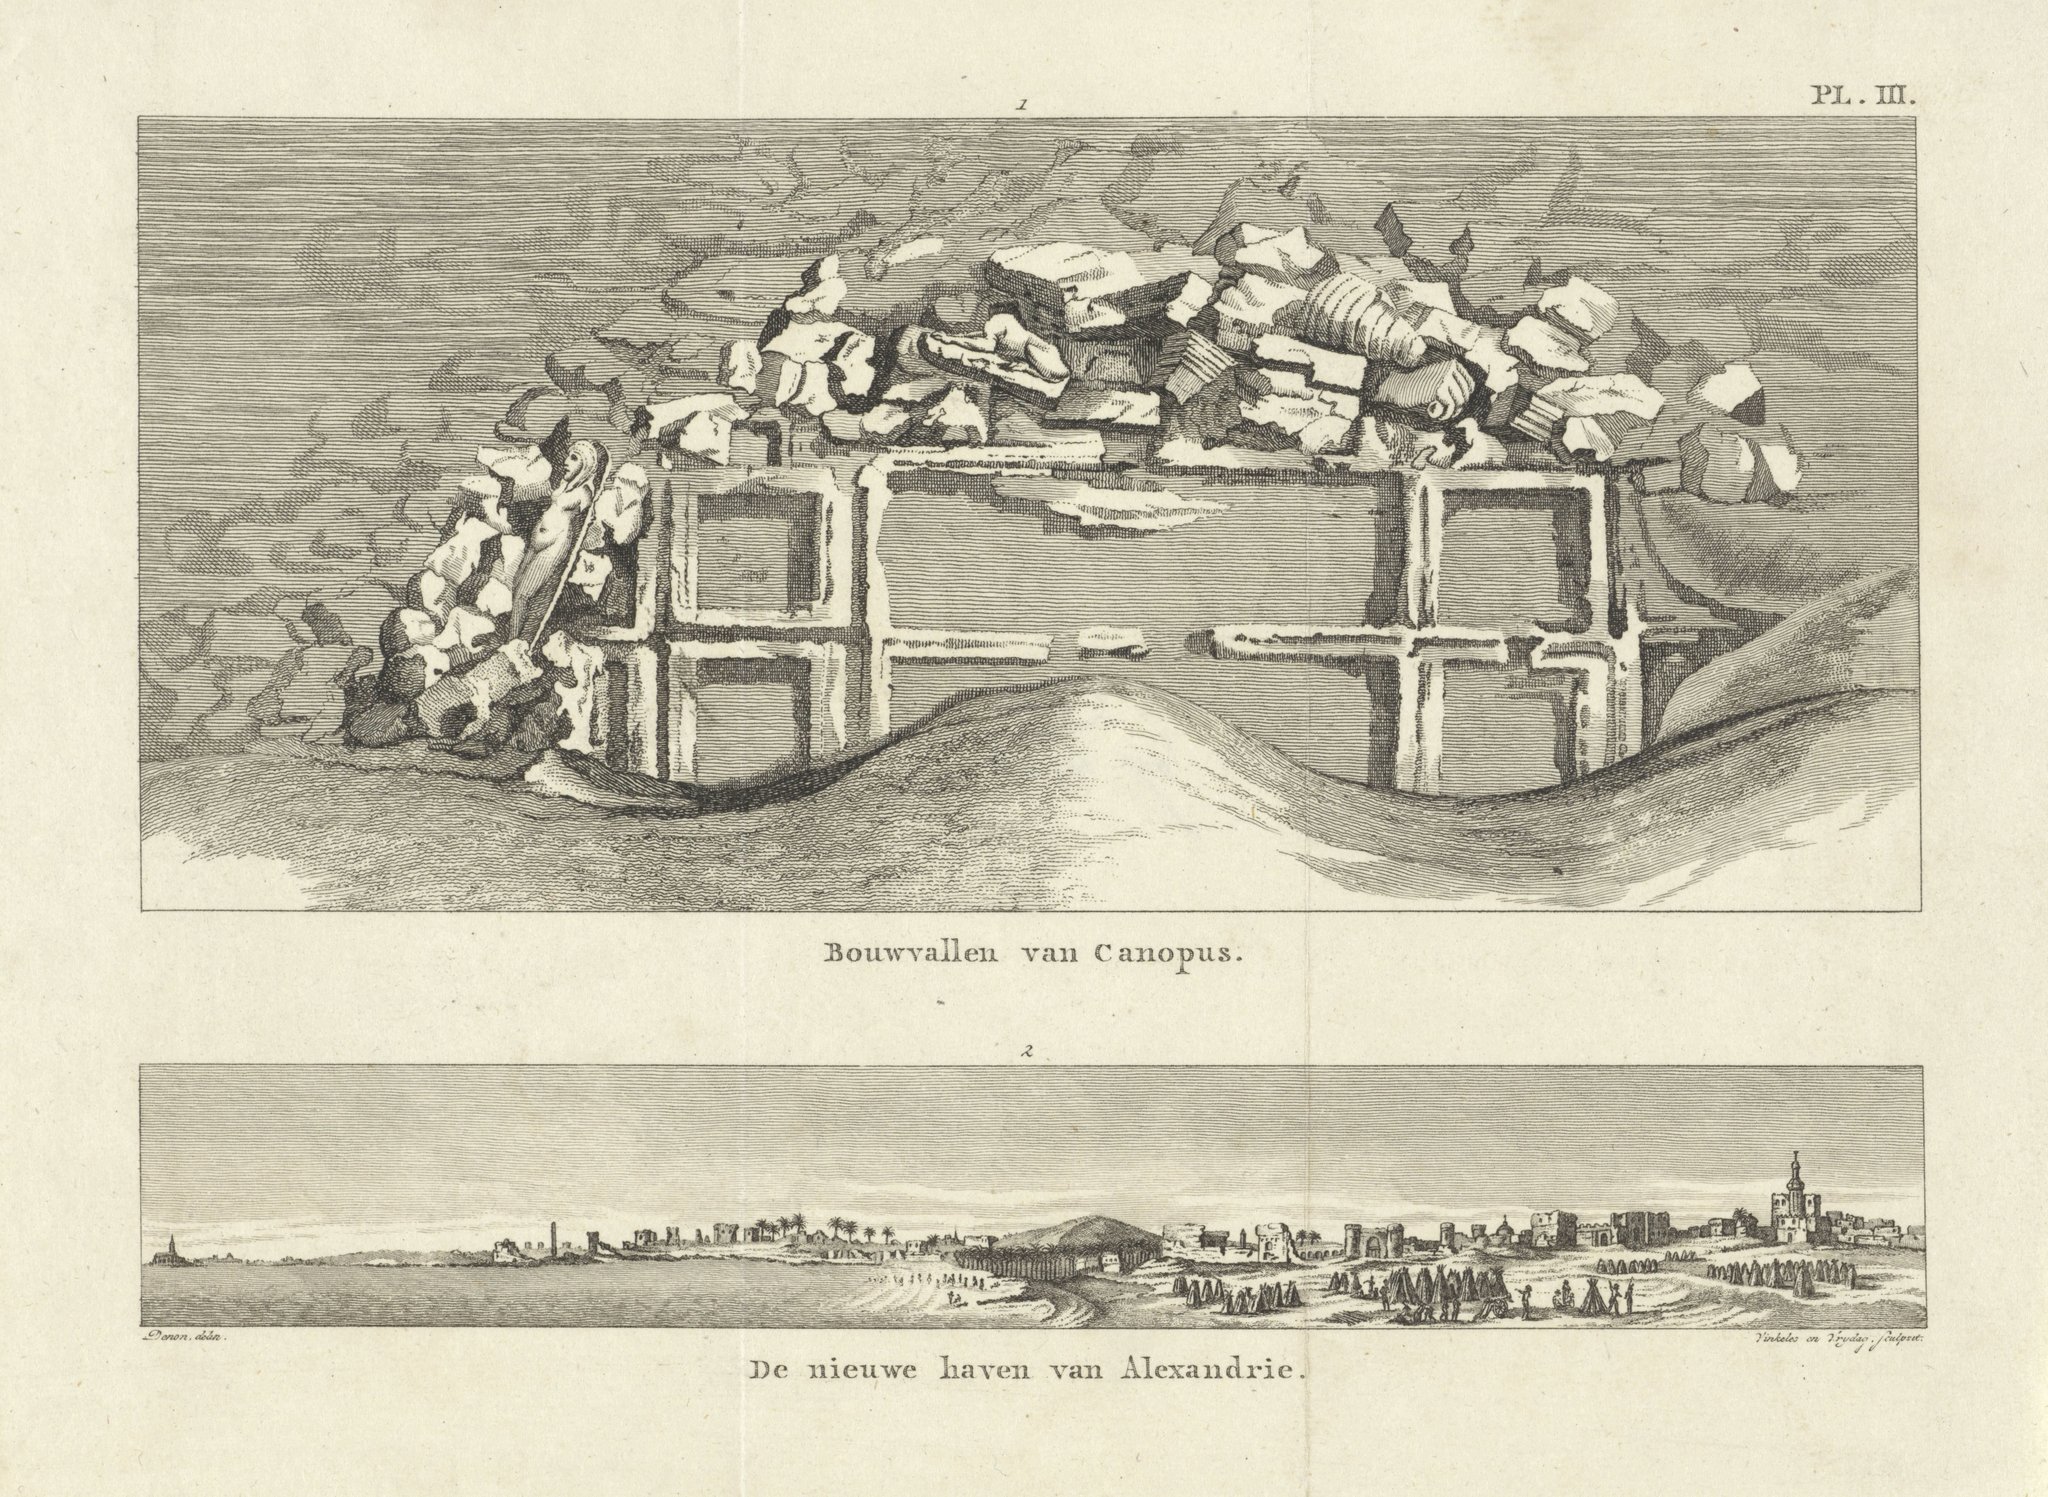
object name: book illustration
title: Bouwvallen van Canopus/ De nieuwe haven van Alexandrie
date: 1803-1805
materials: paper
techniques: etching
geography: amsterdam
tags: harbour, ruin of a building ~ architecture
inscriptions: collector's mark: Lugt 2228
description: Prent vermoedelijk gebruikt in: Denon, Dominique Vivant [vertaald door Herman Bosscha]. Reize in Opper- en Neder-Egipte, gedurende den veldtocht van Bonaparte. 3 dln. Amsterdam: Johannes Allart, 1803-1805.